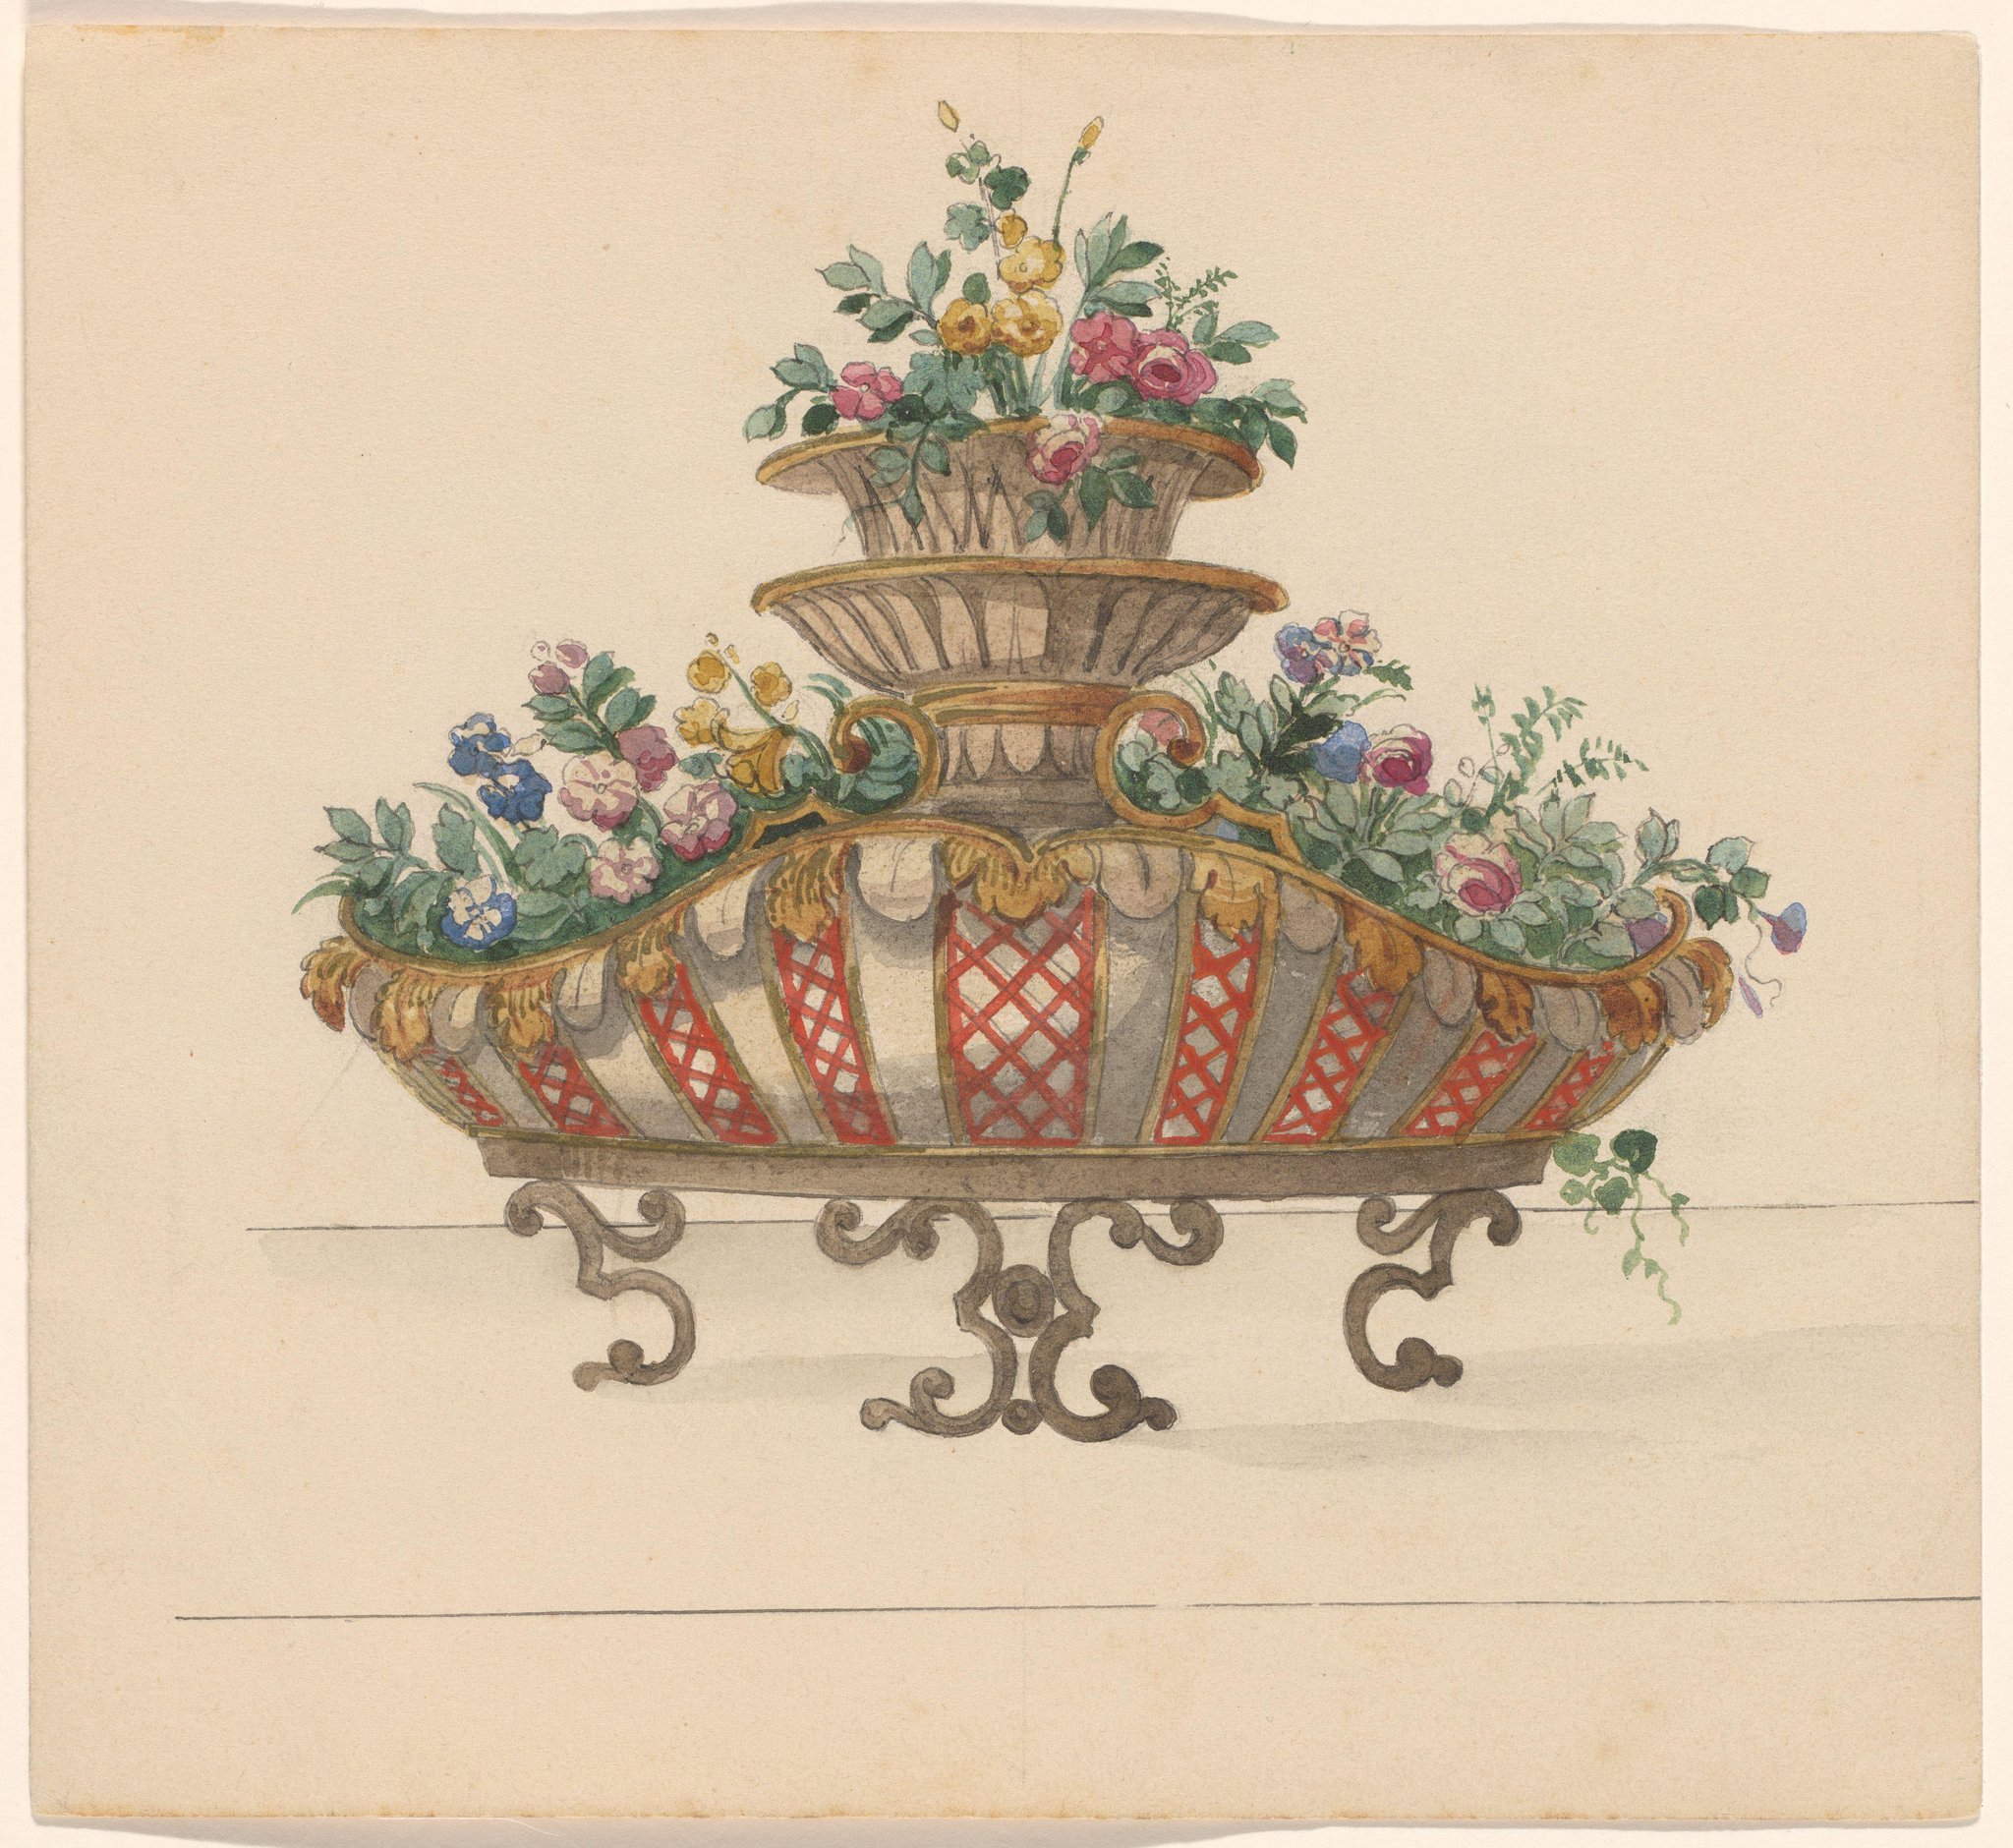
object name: design drawing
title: Jardinière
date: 1830-1850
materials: paint, ink, paper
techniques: aquarelle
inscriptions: inscription: ‘HEINRICH JENNY’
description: Jardinière in de vorm van een grijs met rode bak met opstand op een grijs onderstel.